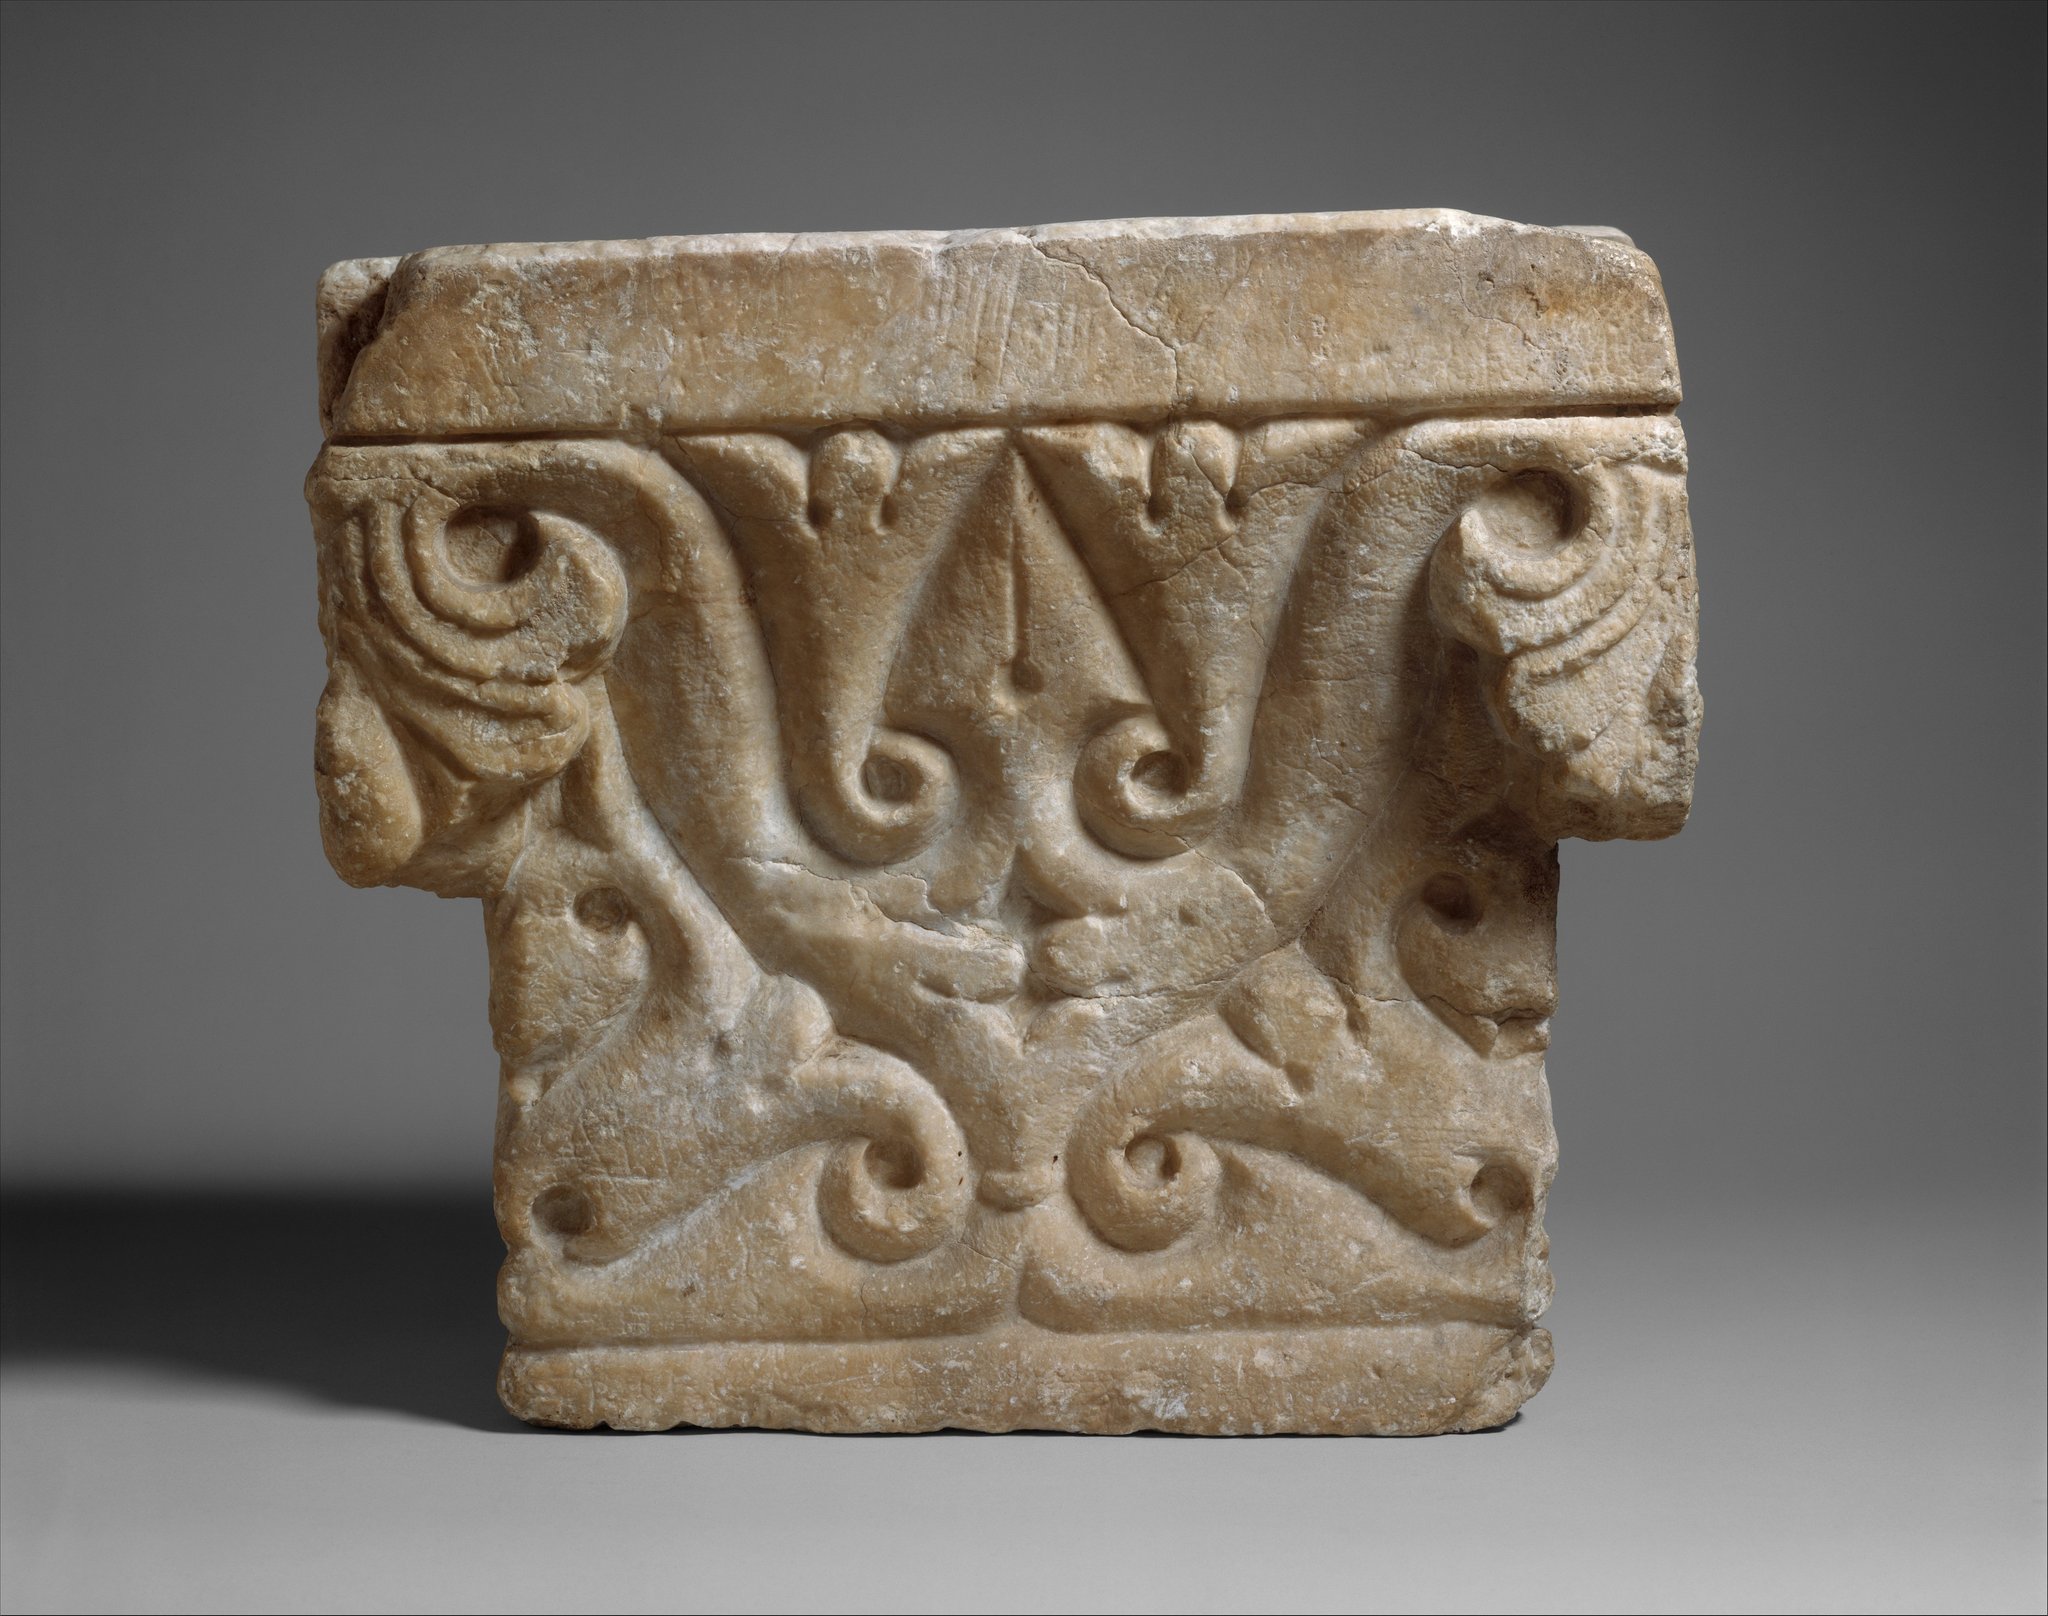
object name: capital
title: Capital in the "Beveled Style"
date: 767-800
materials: alabaster, gypsum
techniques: carving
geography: syria